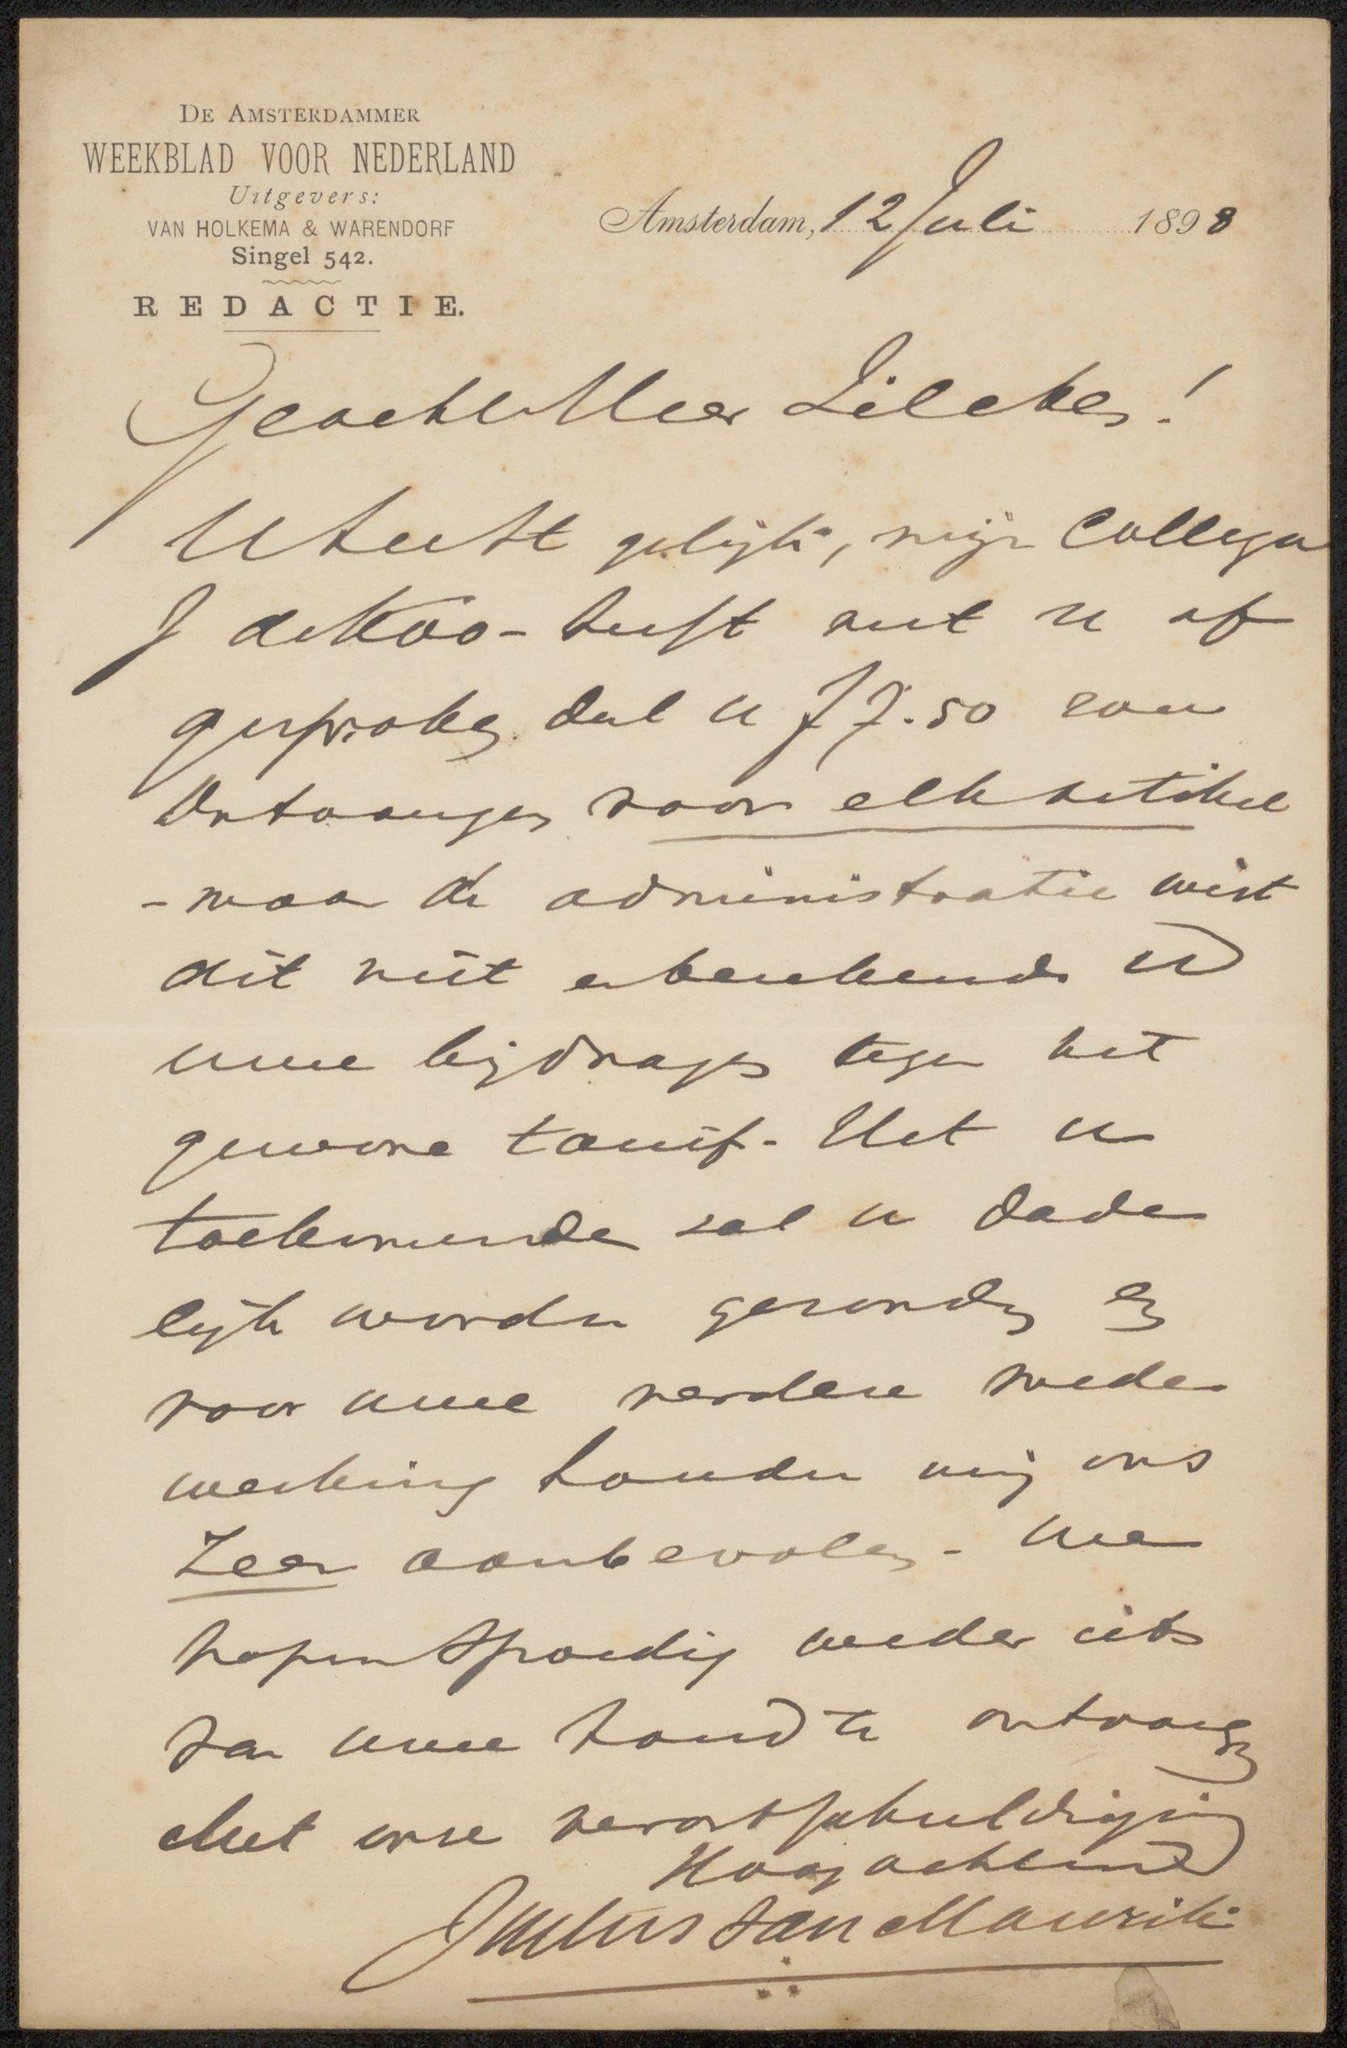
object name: letter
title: Brief aan Philip Zilcken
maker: justus van maurik jr.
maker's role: schrijver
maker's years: 1846-1904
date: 1898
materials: ink, paper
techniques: pen, printing, writing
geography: amsterdam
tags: liège, johannes de koo, the hague, draughtsman, philip zilcken, literature ~ arts, money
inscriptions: collector's mark: ‘RPK’